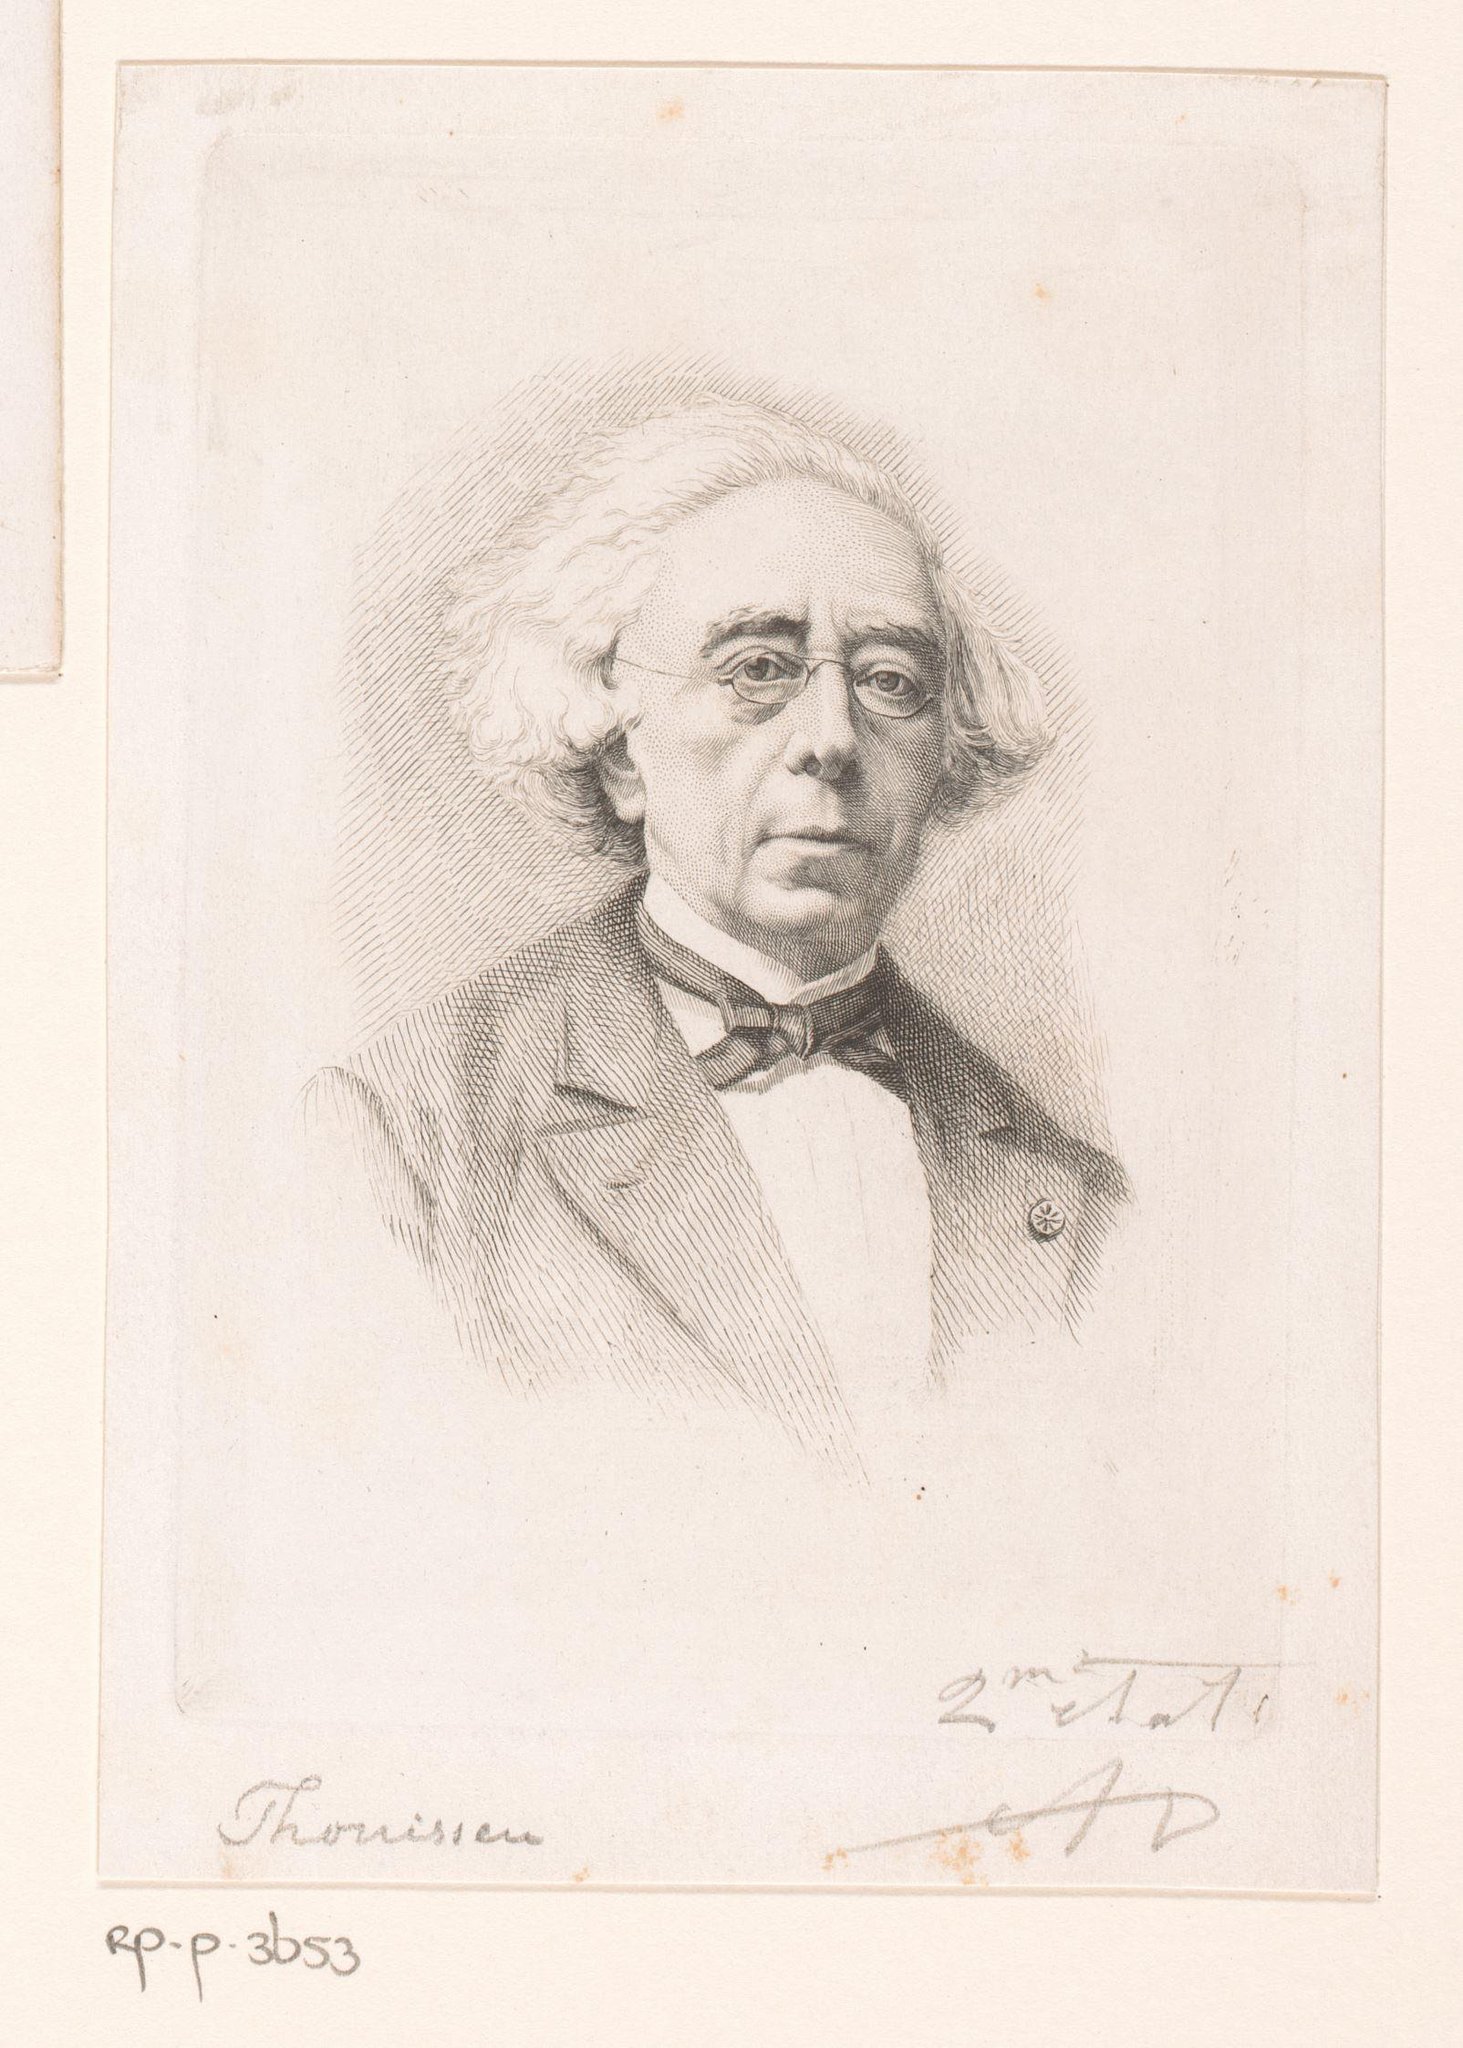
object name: print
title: Portret van Jean Joseph Thonissen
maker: auguste danse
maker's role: print maker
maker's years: 1829-1929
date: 1839-1909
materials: paper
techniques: etching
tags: louvain, politician, jean-joseph thonissen, historical person (...) - historical person (...) portrayed alone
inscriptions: collector's mark: Lugt 2228, annotation: ‘2me état’